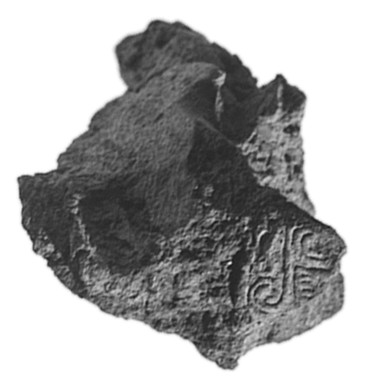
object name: sealing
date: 2030-1640 BCE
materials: clay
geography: egypt